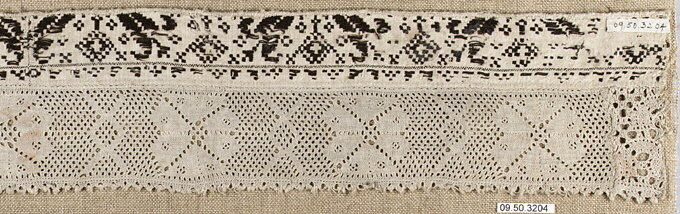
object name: strip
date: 1701-1800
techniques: lace